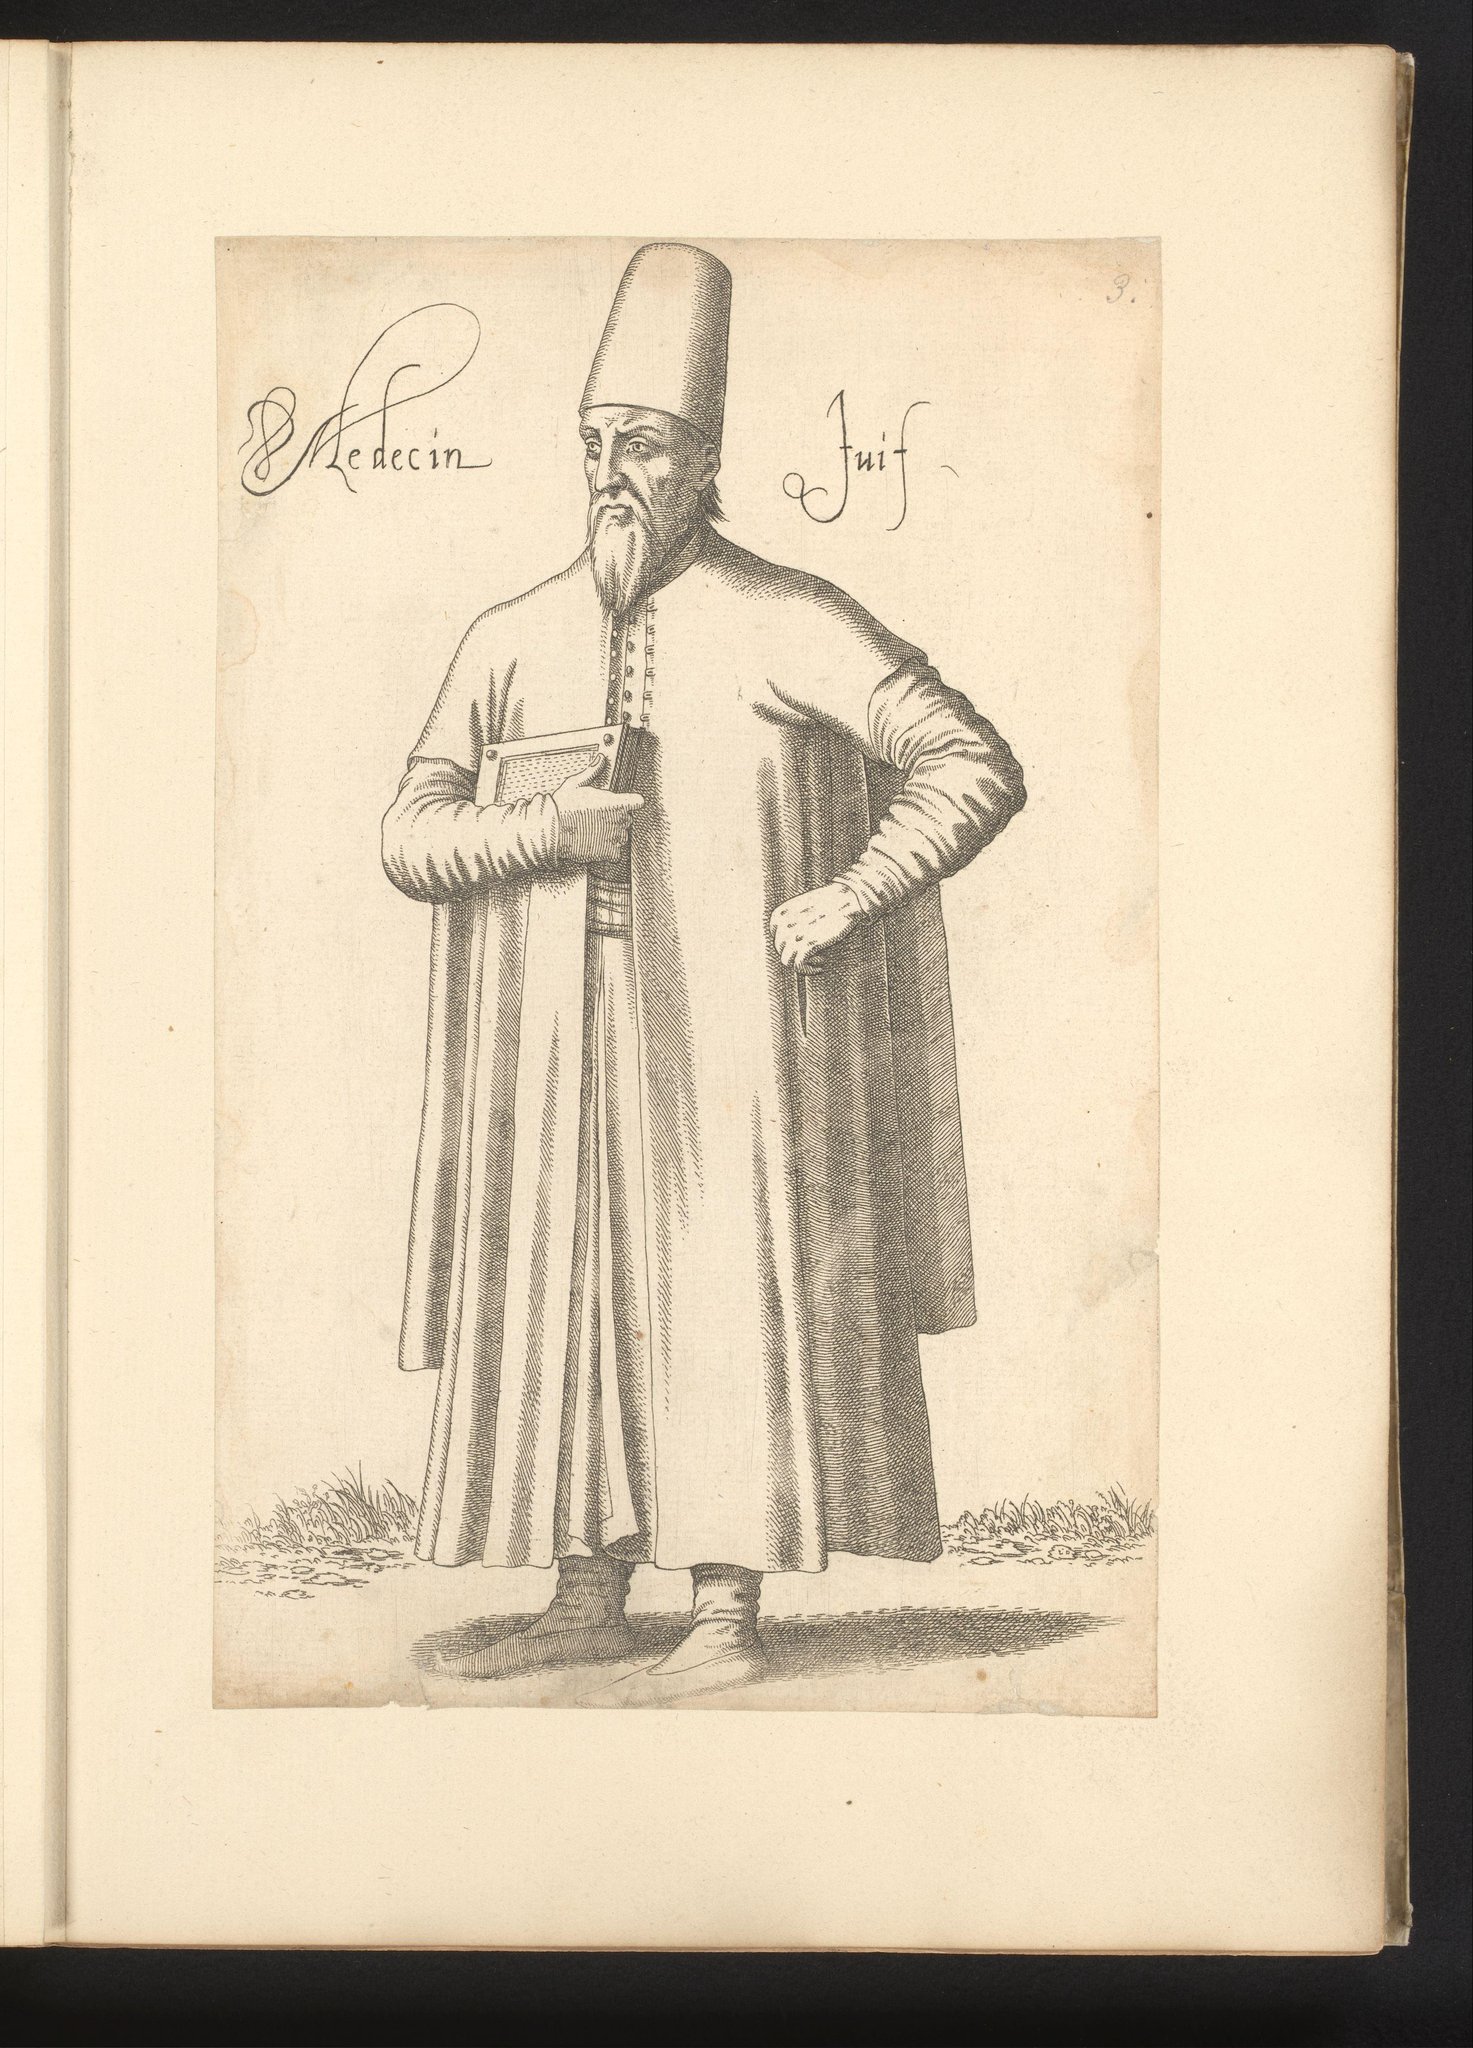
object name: album leaf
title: Medecin Juif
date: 1555-1568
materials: paper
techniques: etching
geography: lyon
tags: physician, doctor, the jews, jewish life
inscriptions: collector's mark: Lugt 2228, collector's mark: Lugt 2760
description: Prent uit: Nicolay, Nicolas de. Les quatre premiers livres des navigations et pérégrinations orientales, de N. de Nicolay, (...) Avec les figures au naturel tant d'hommes que de femmes selon la diversité des nations, & de leur port, maintien & habitz. Lyon: Guillaume (I) Rouille, 1568.